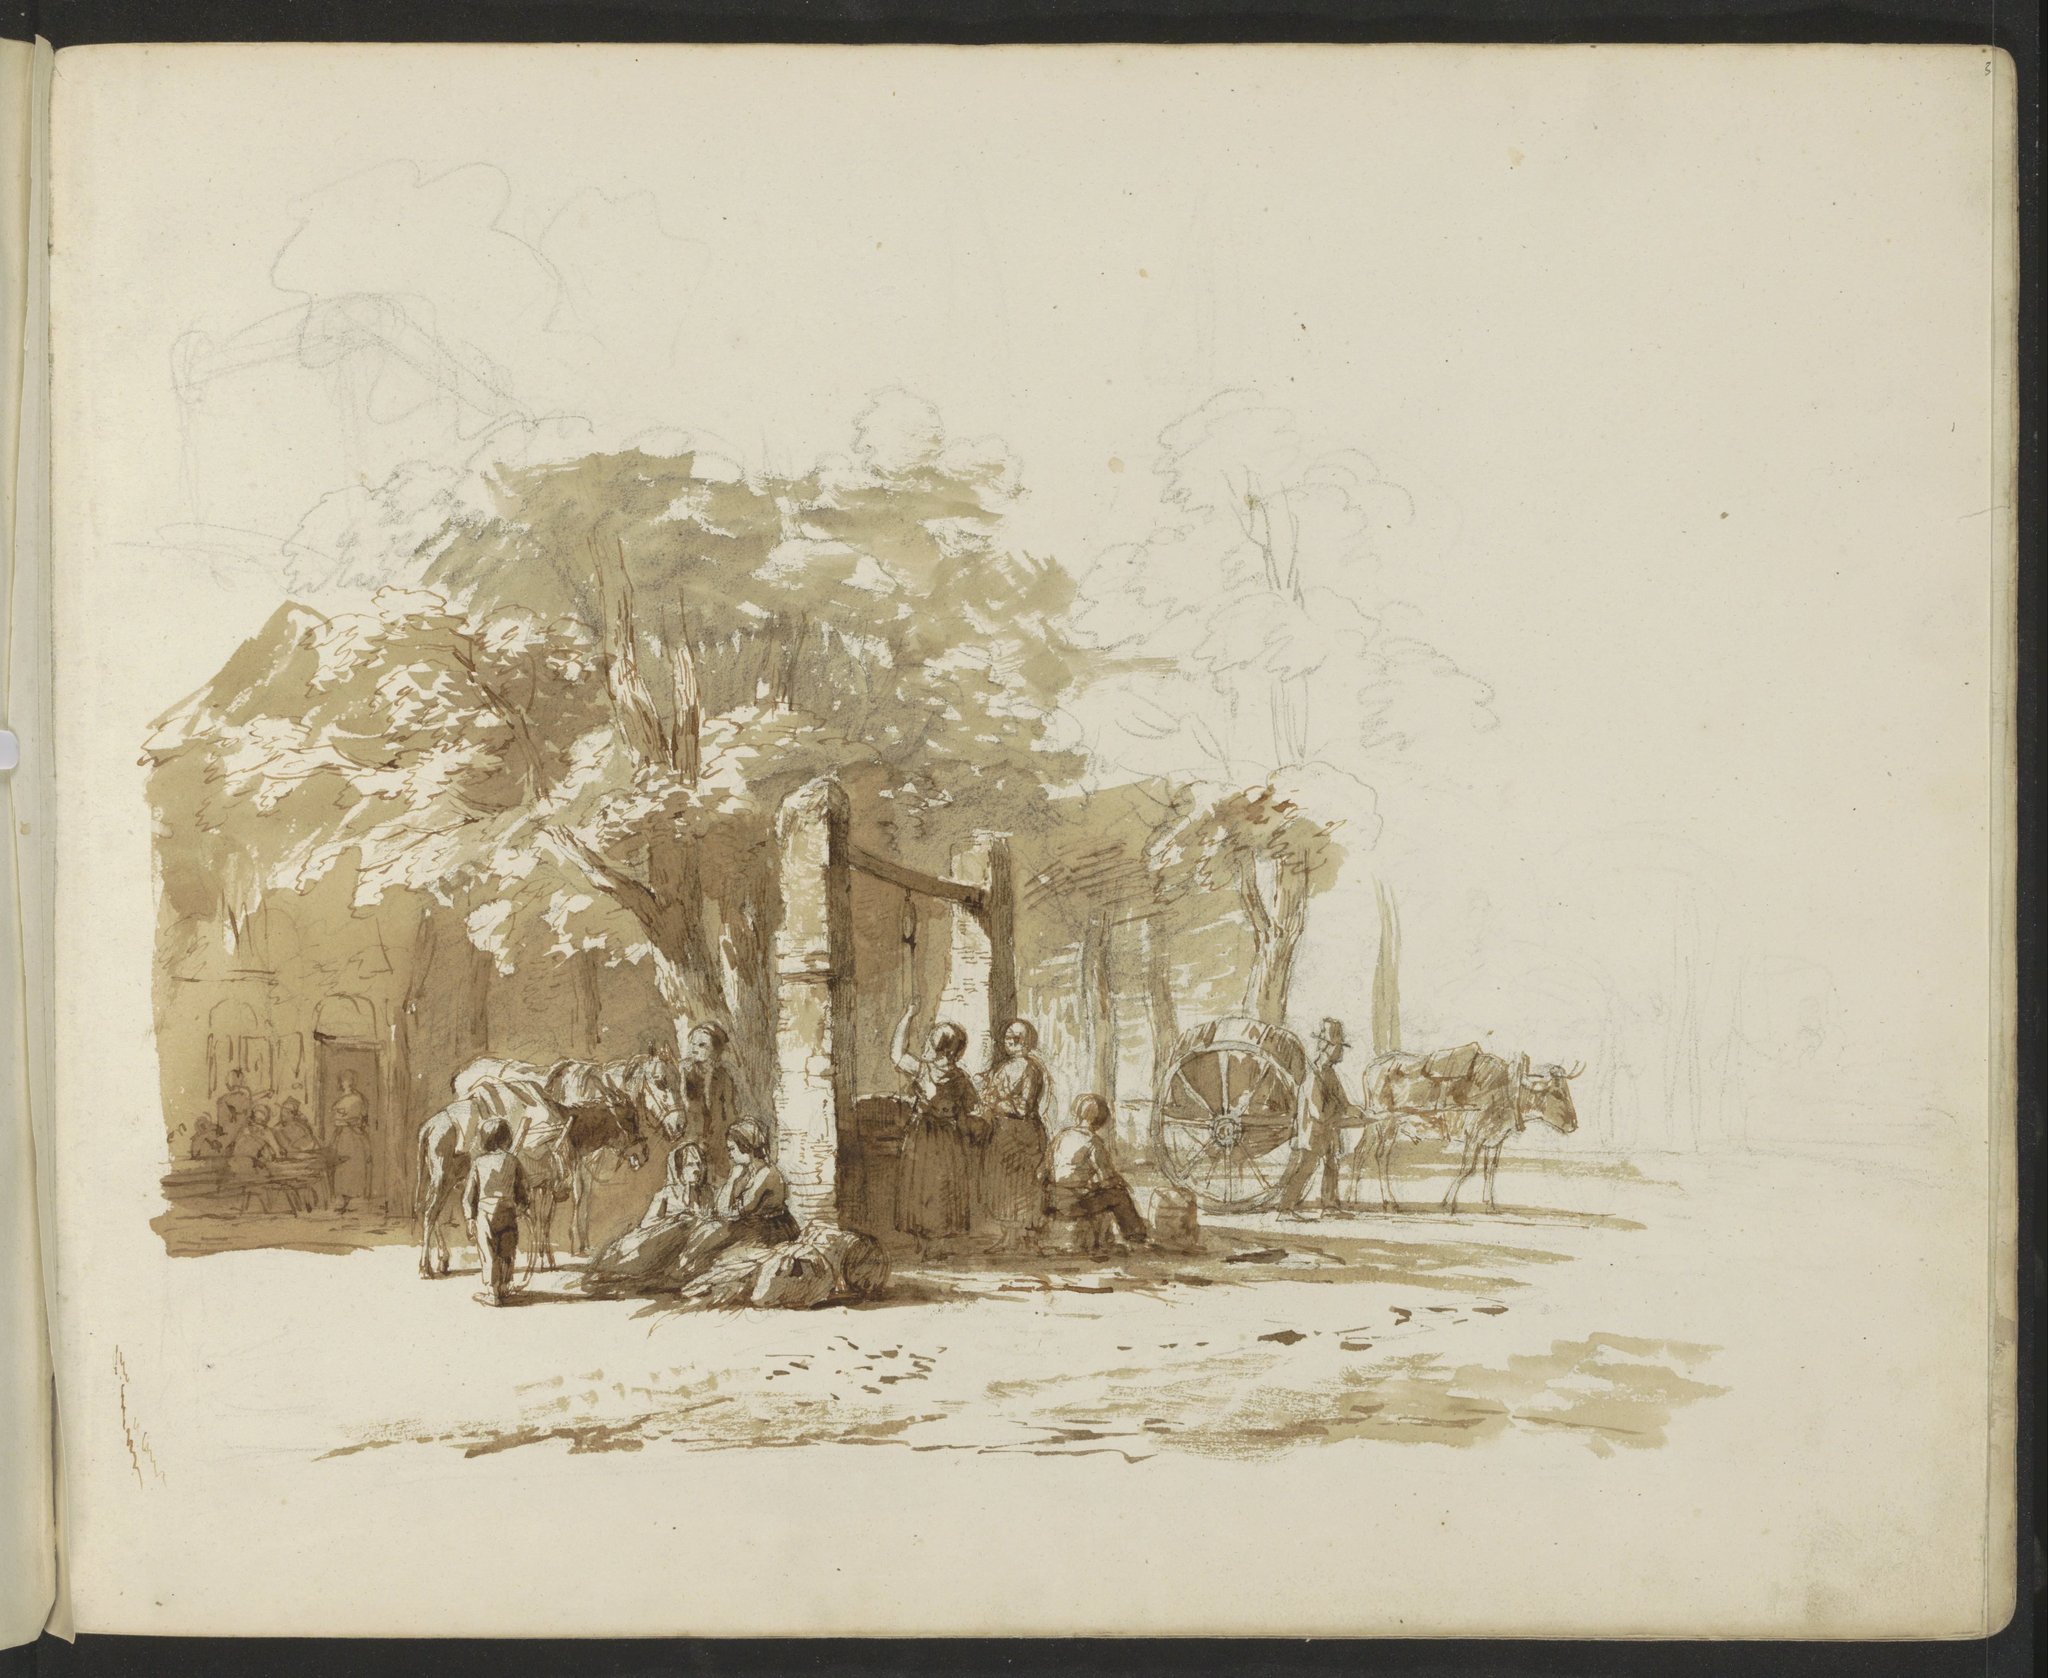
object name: sketchbook leaf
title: Figuren bij een waterput op een dorpsplein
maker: Anonymous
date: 1800-1899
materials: chalk, ink, paper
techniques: brush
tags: well, village square, place (+ city(-scape) with figures, staffage)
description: Op een boomrijk dorpsplein staat een groep figuren met ezels bij een waterput. Op de achtergrond zitten figuren voor een taveerne en loopt een man met een ossenkar. Blad 3 recto uit een schetsboek met 13 bladen.